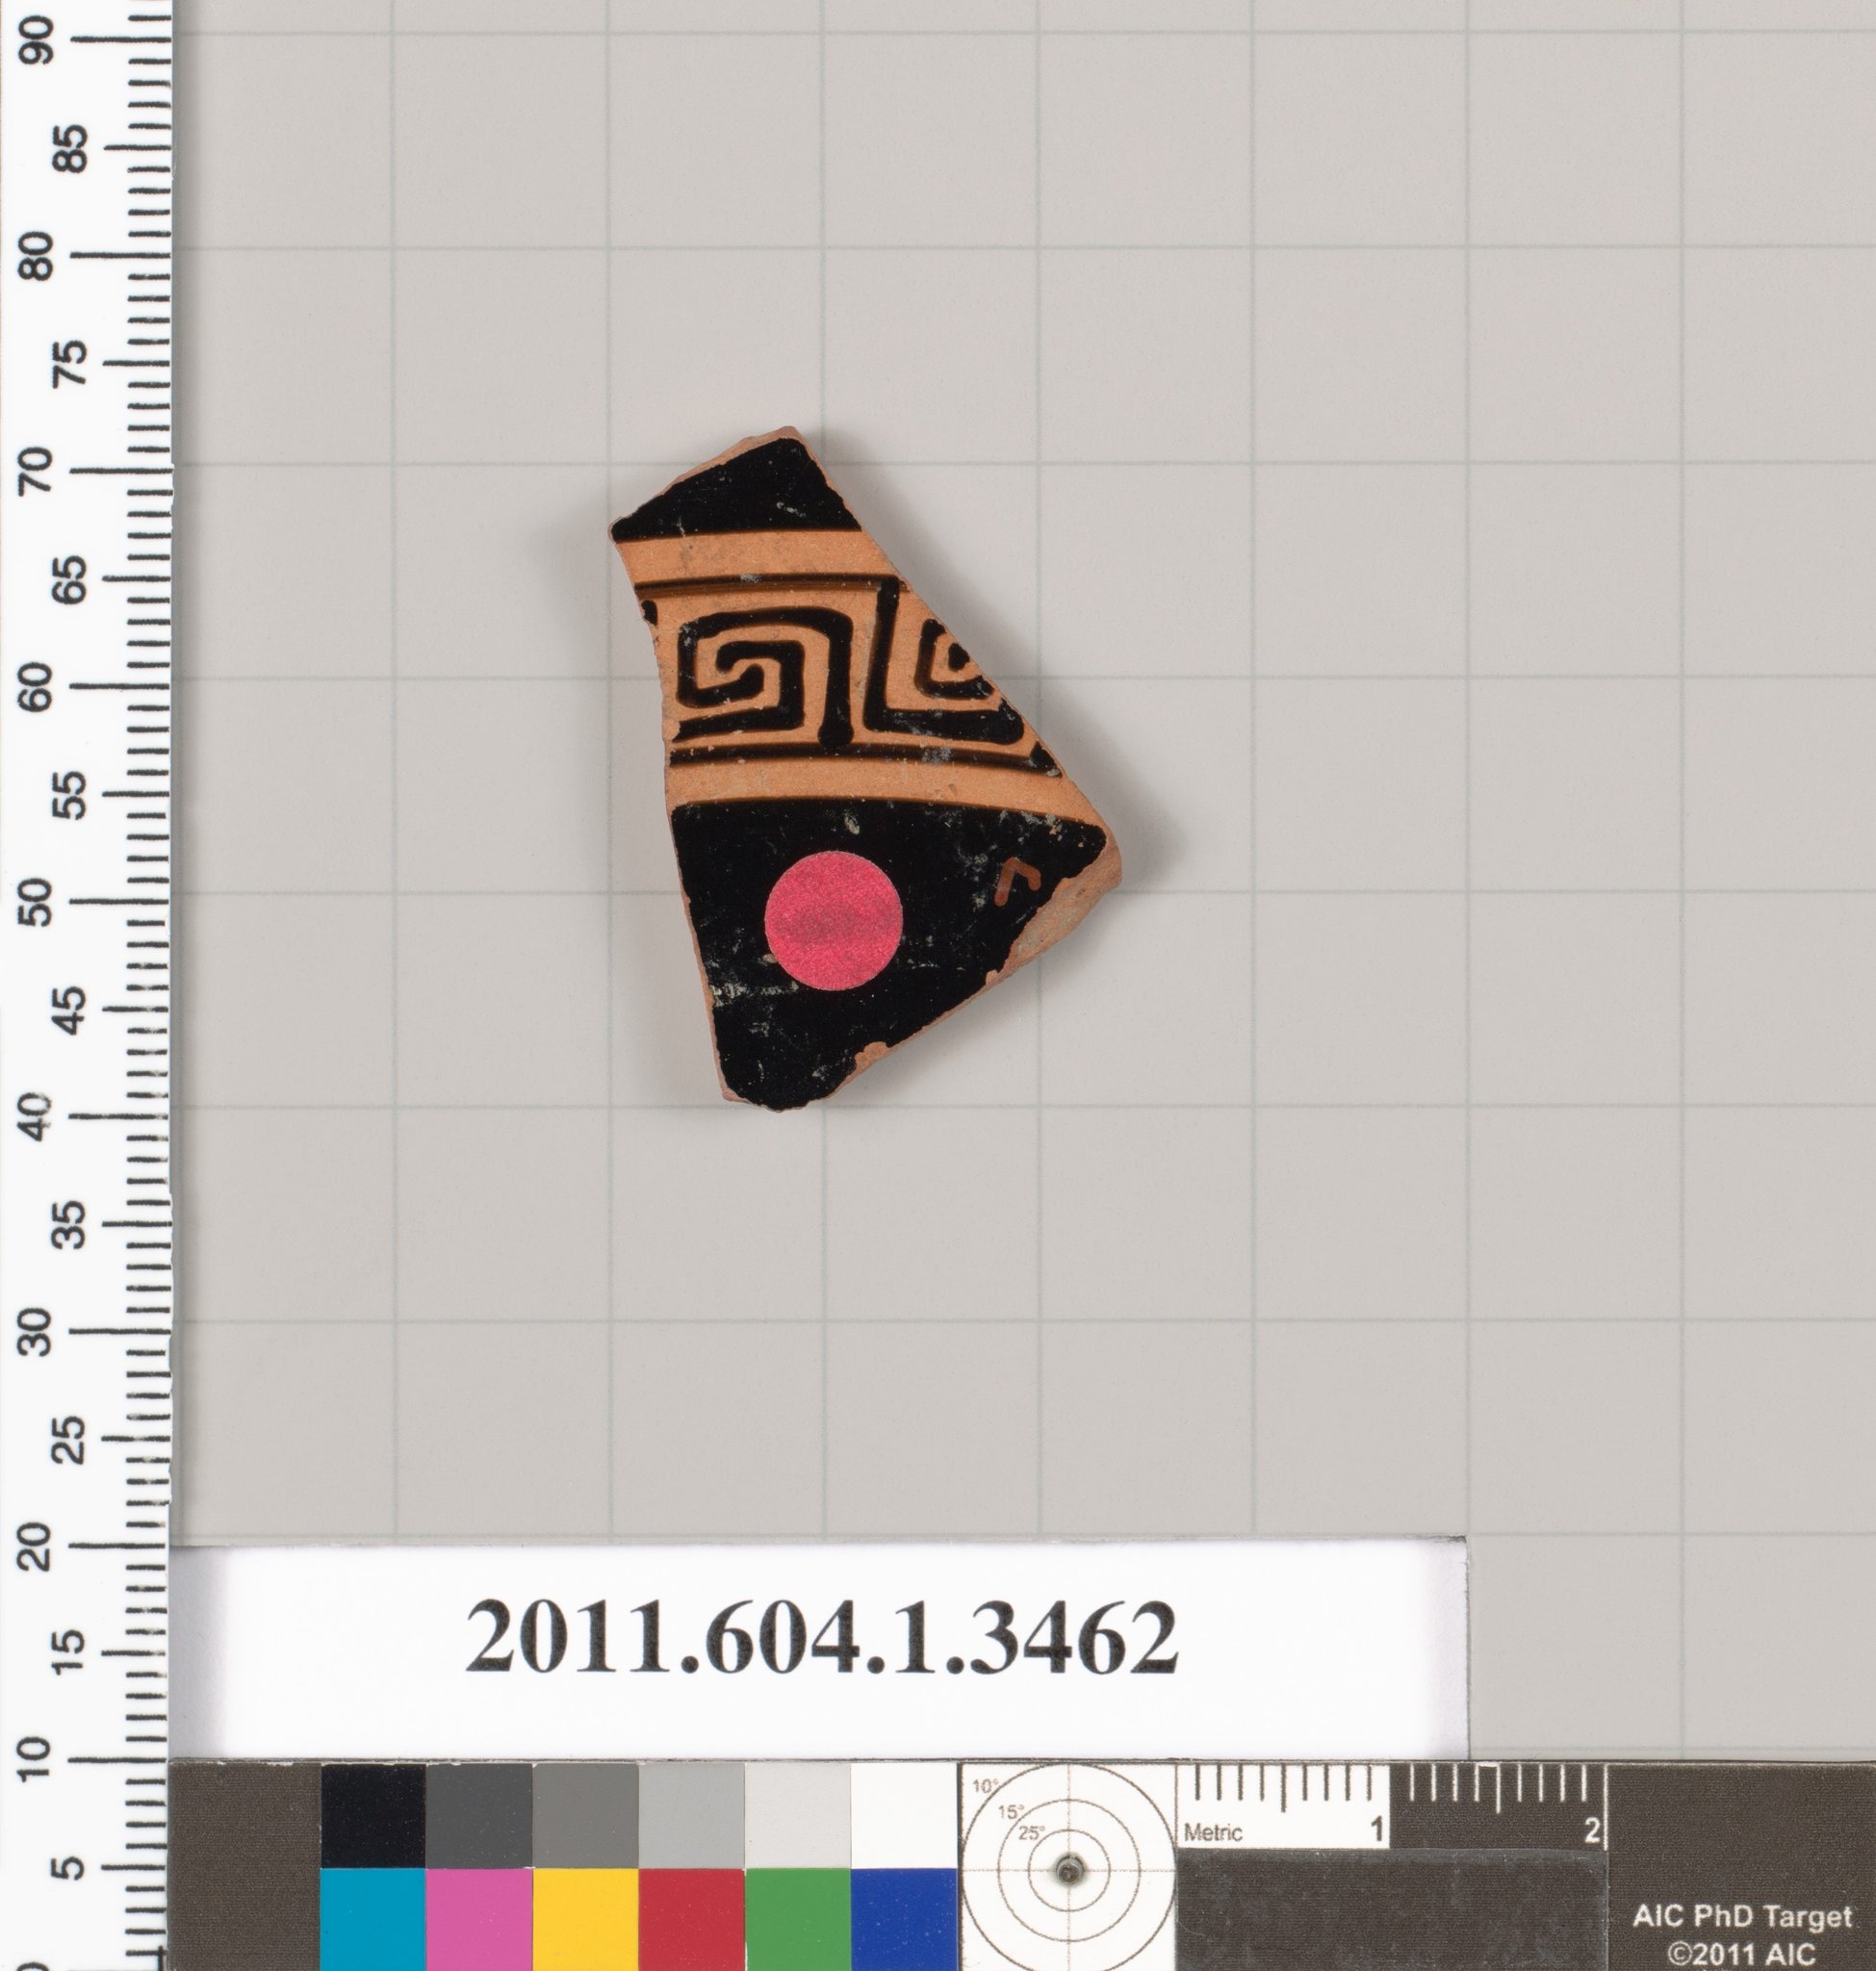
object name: kylix fragment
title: Terracotta fragment of a kylix (drinking cup)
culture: greek, attic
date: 500-476 BCE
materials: terracotta